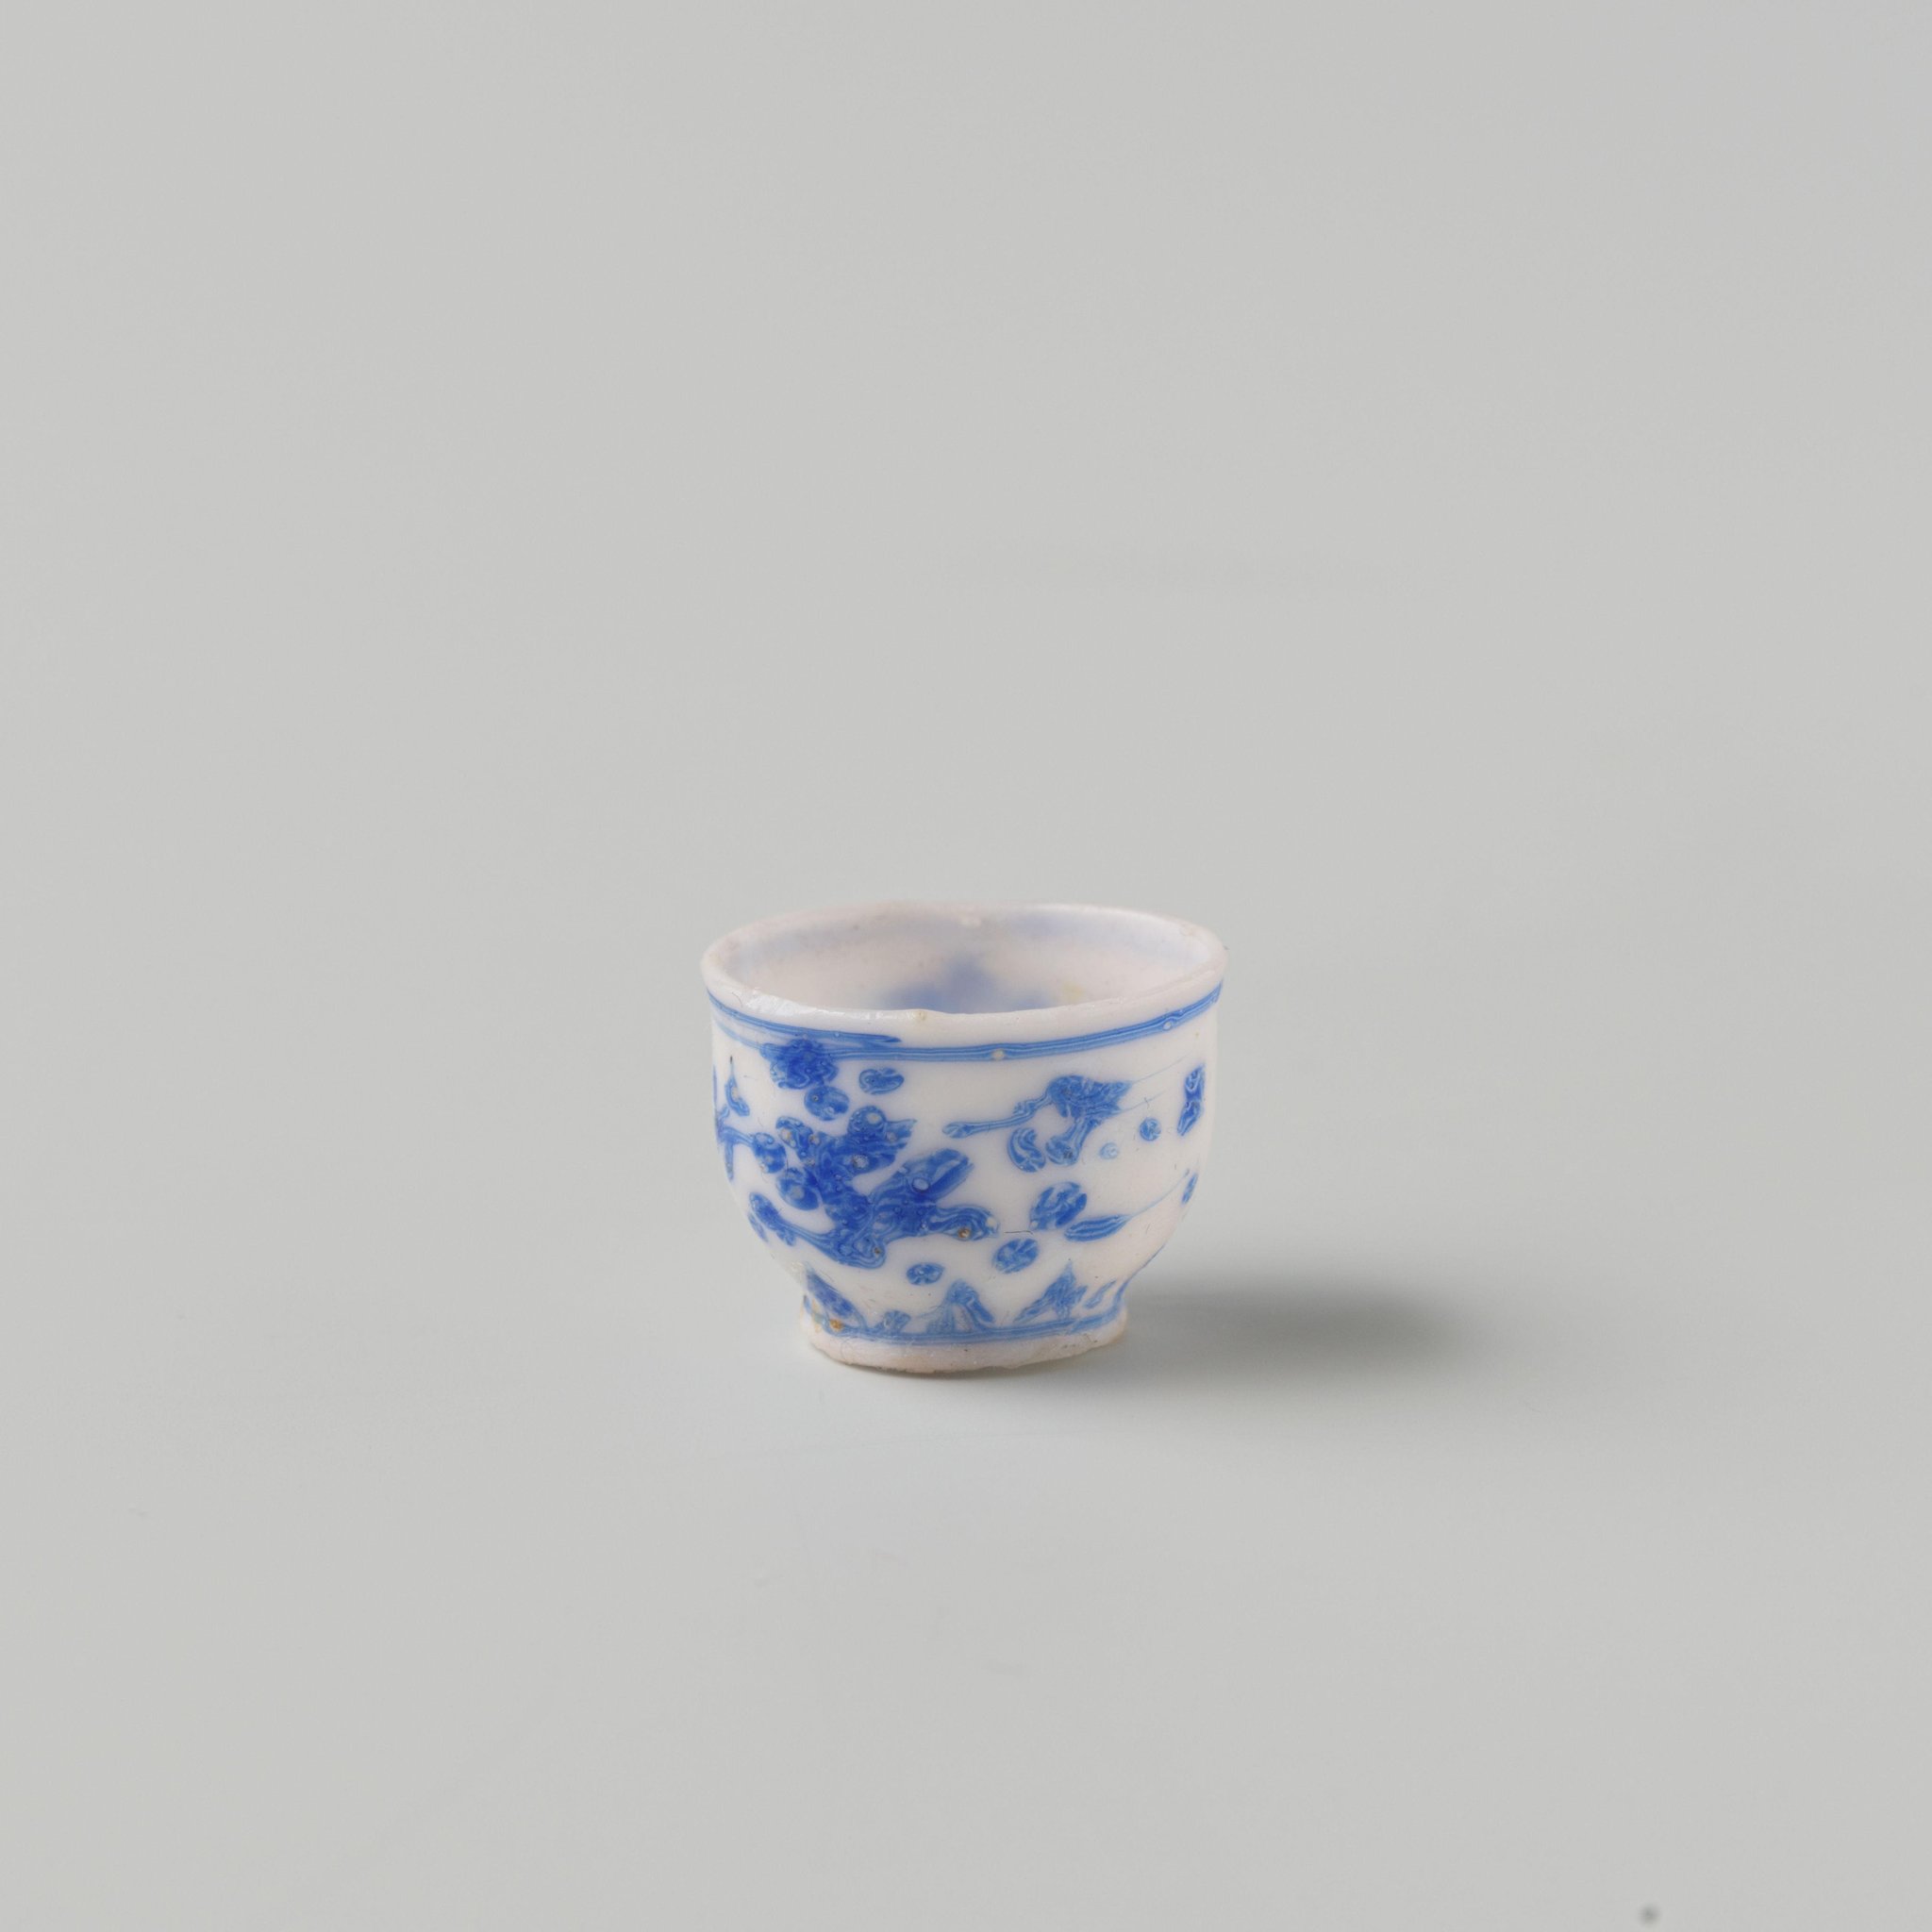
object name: miniature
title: Kleine kom van melkglas met blauwe emailverf beschildering, imitatie Chinees porselein; decoratie van twee 'bloemtakken'.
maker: Anonymous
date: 1675-1710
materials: glass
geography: amsterdam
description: Kleine kom van melkglas met blauwe emailverf beschildering, imitatie Chinees blauw porselein; met decoratie van bloesemtakken.